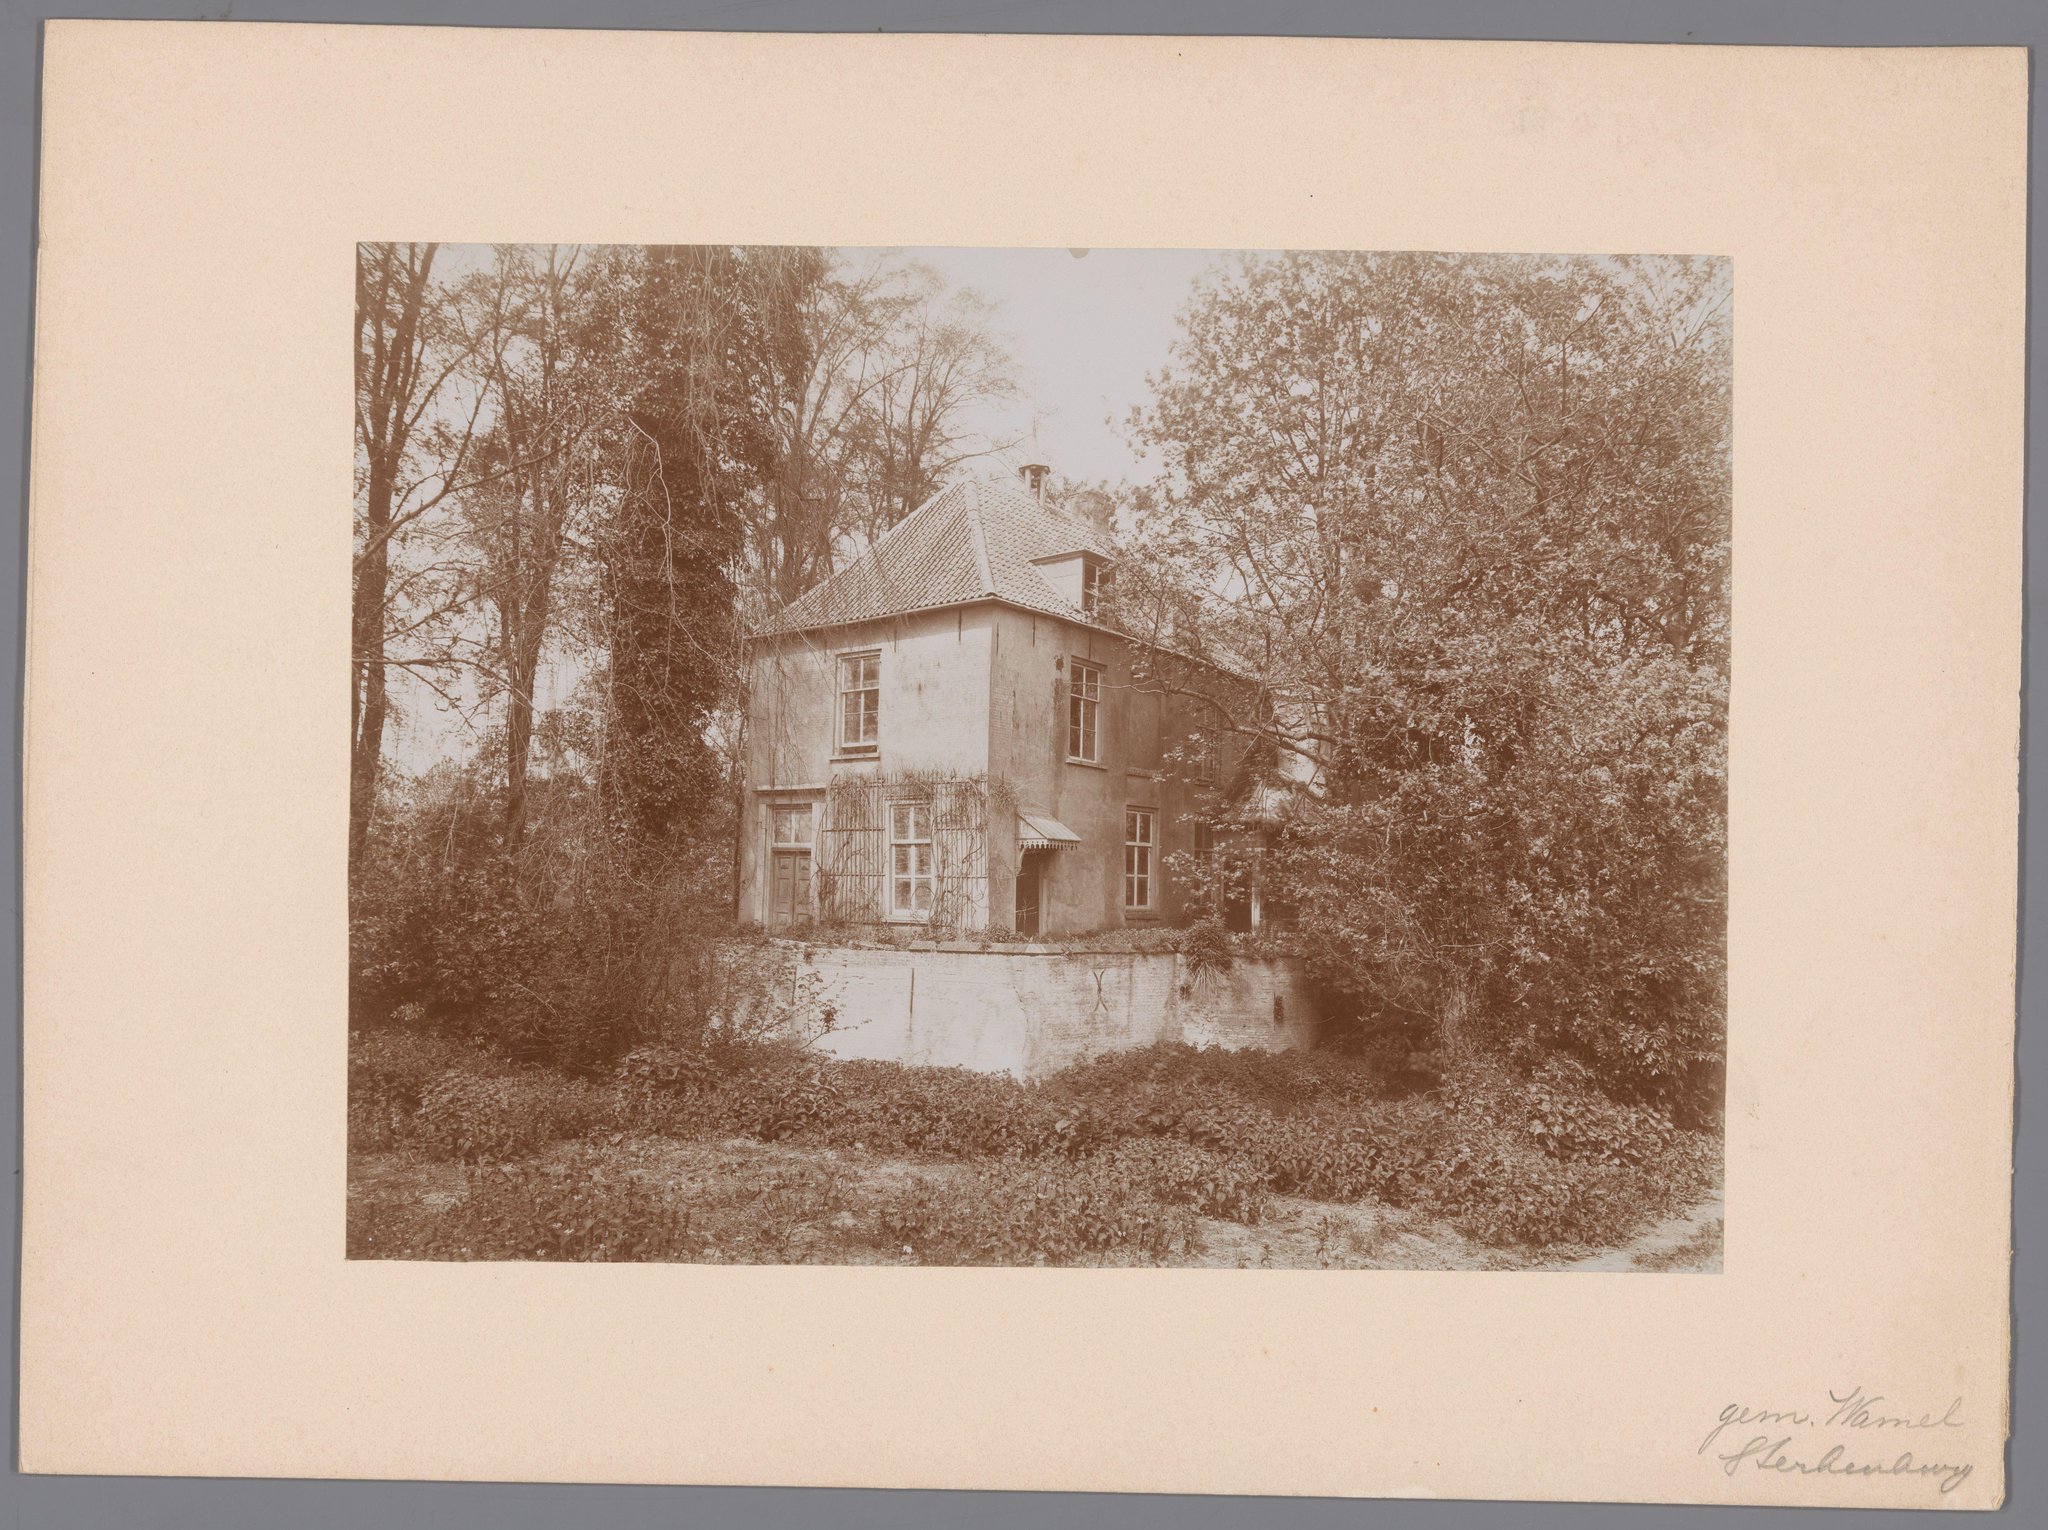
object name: photograph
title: Gezicht op Kasteel Sterkenburg te Wamel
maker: anoniem (monumentenzorg)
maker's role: fotograaf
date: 1905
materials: cardboard, photographic support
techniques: collodion silver print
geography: wamel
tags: castle, landscape with tower or castle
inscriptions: annotation: ‘Huize Serkenburg (G.)/ Onder de gemeente Wamel bij Tiel/ Mei 1905’, annotation: ‘gem. Wamel/ Sterkenburg’